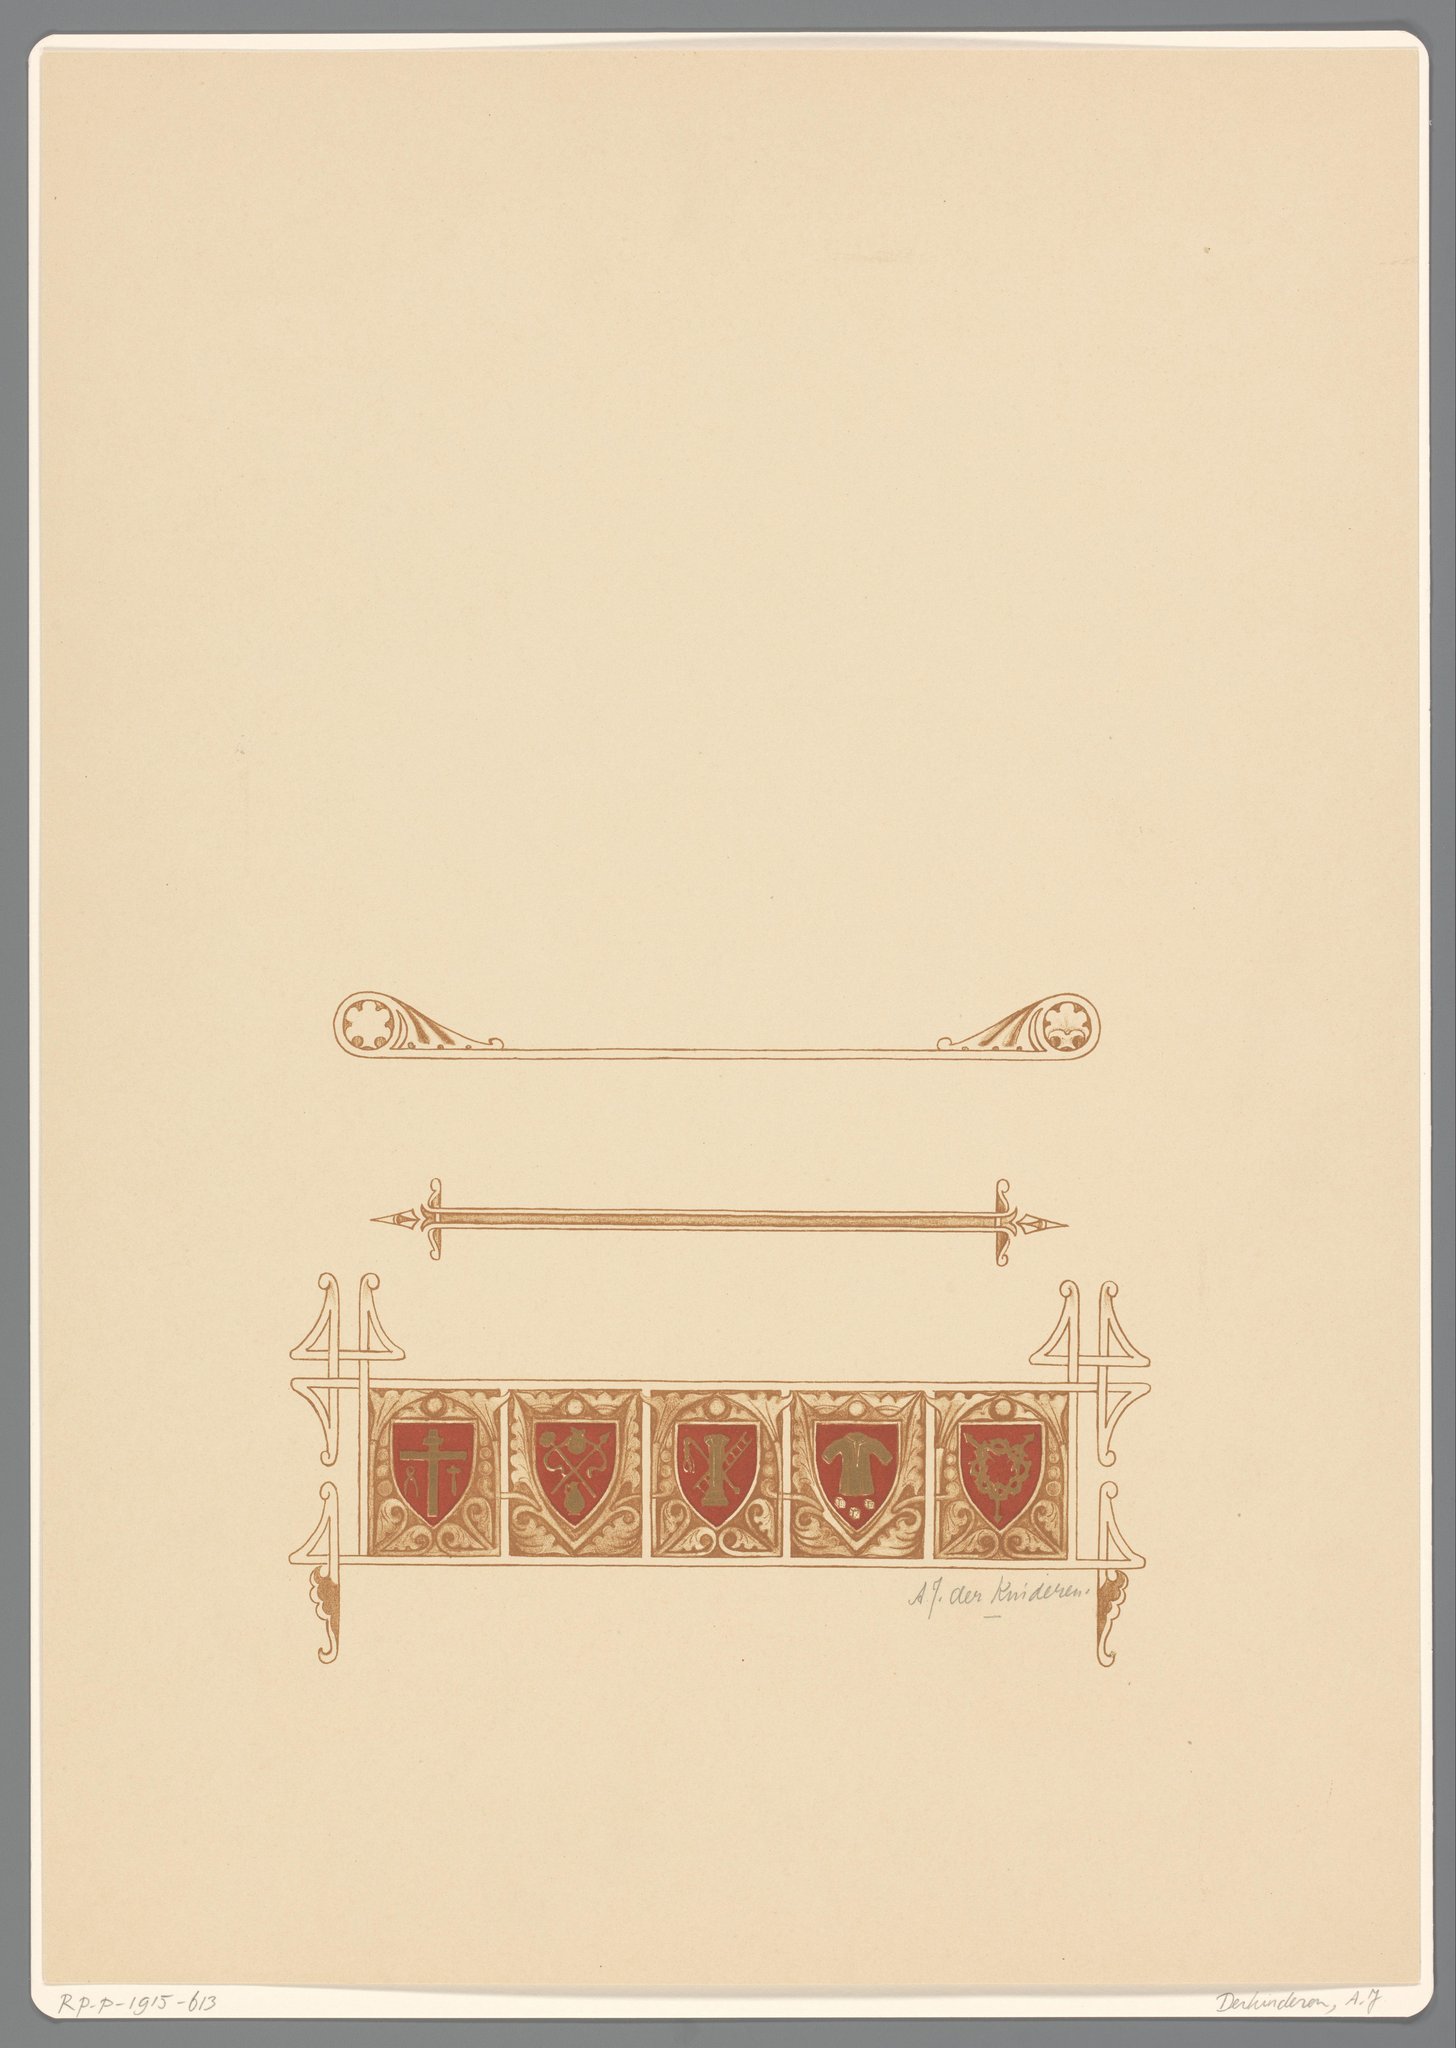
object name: book illustration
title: Vijf wapenschilden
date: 1894-1901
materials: paper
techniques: lithograph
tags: coat of arms (as symbol of the state, etc.)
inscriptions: collector's mark: Lugt 2233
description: Prent gebruikt voor: Vondel, Joost van den. Gysbreght van Aemstel. Haarlem: Erven F. Bohn, 1894-1901. De voorstelling is door Tresling & Comp. op steen overgebracht.